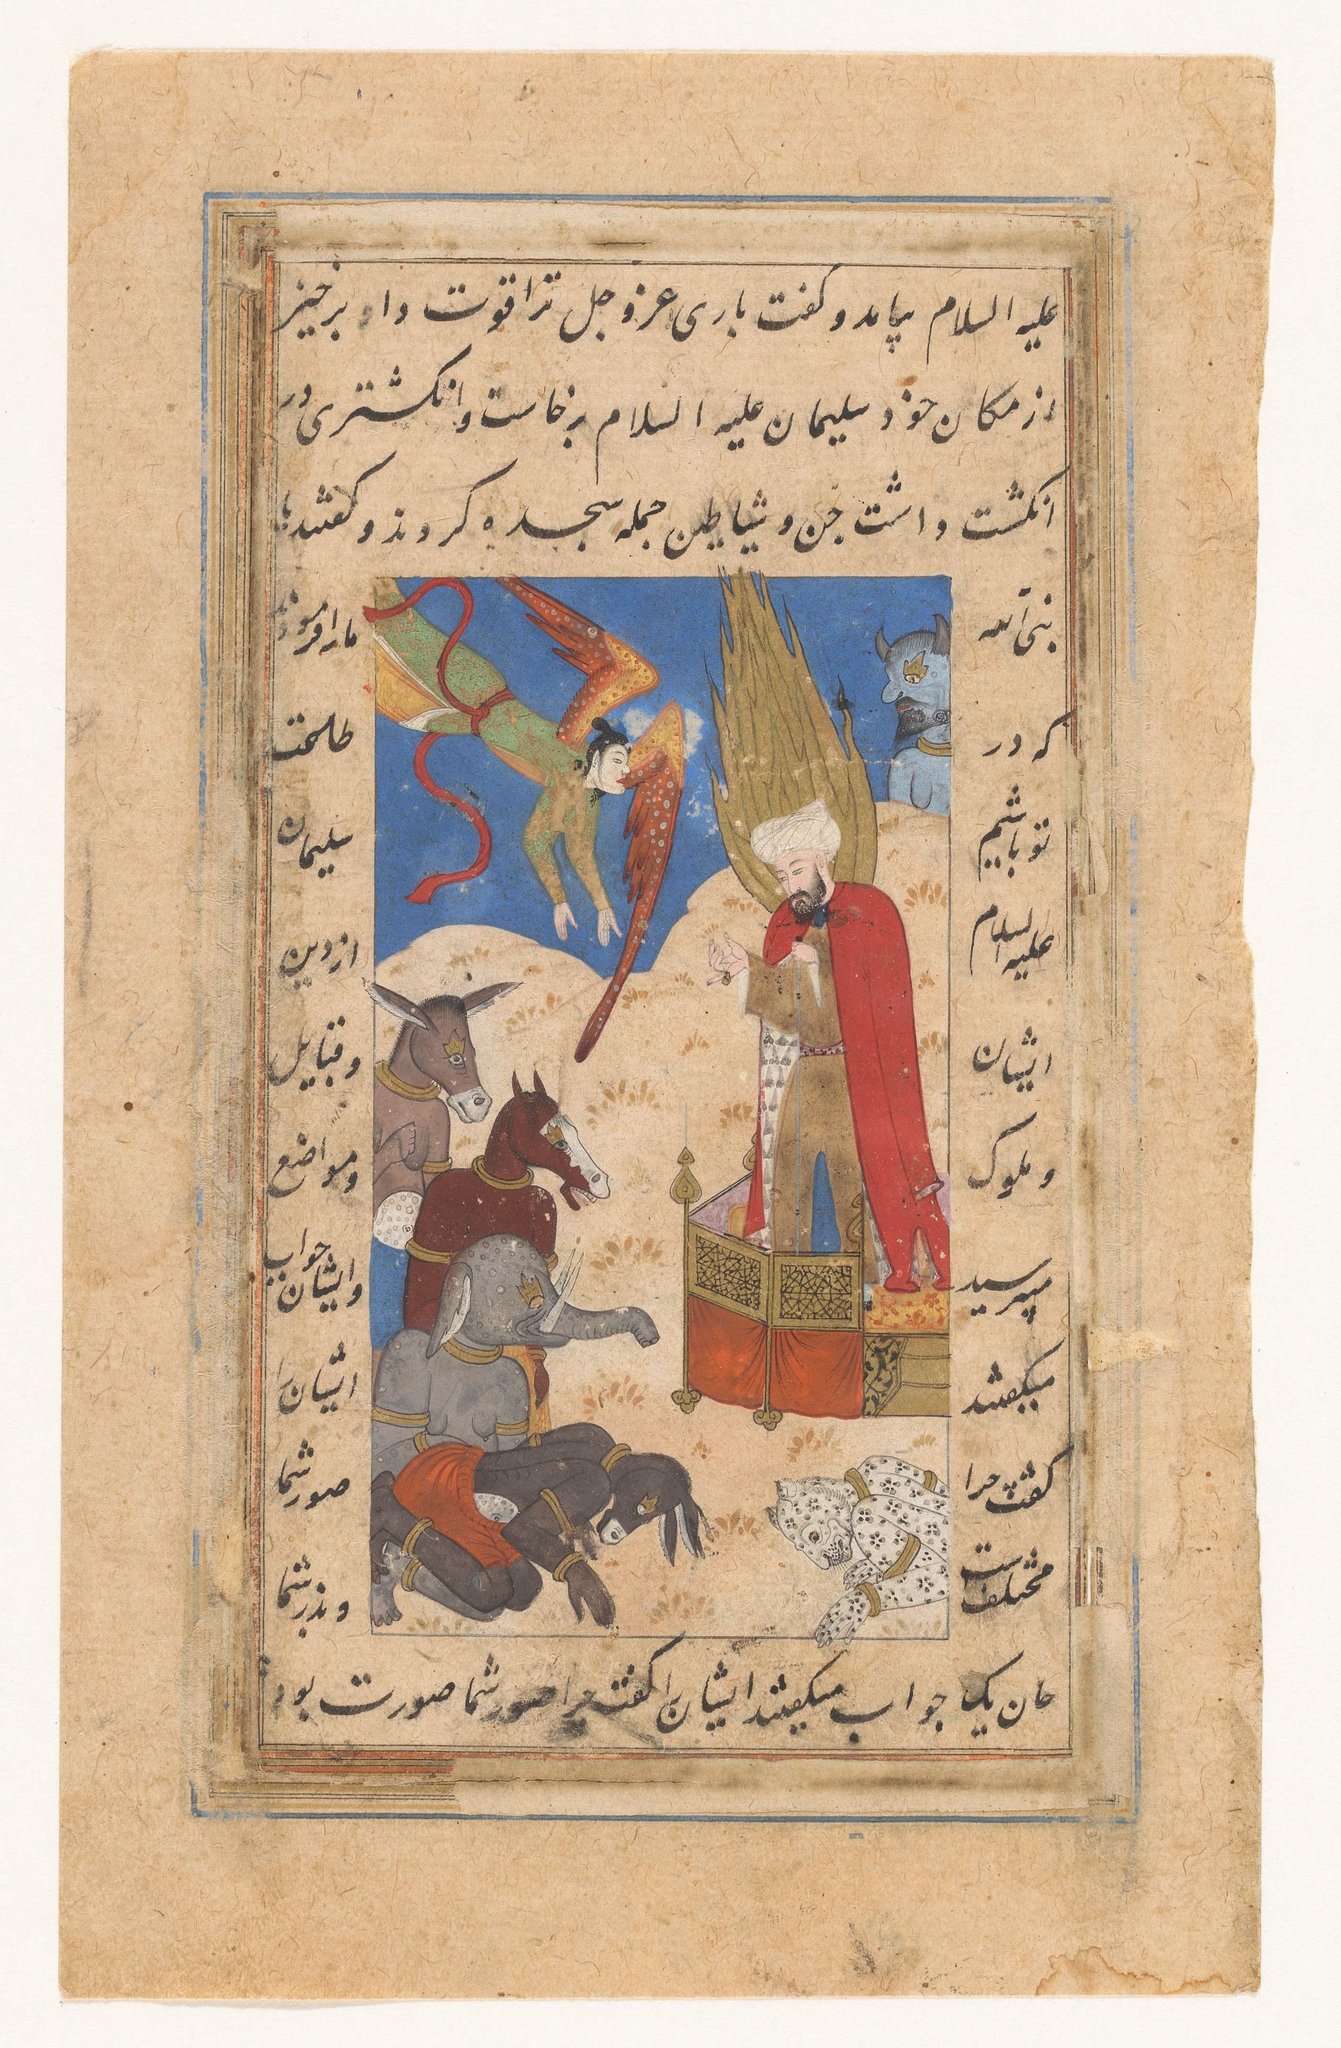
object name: persian miniature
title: Profeet in de wildernis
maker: Anonymous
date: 1500-1800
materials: paper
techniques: brush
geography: iran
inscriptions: inscription